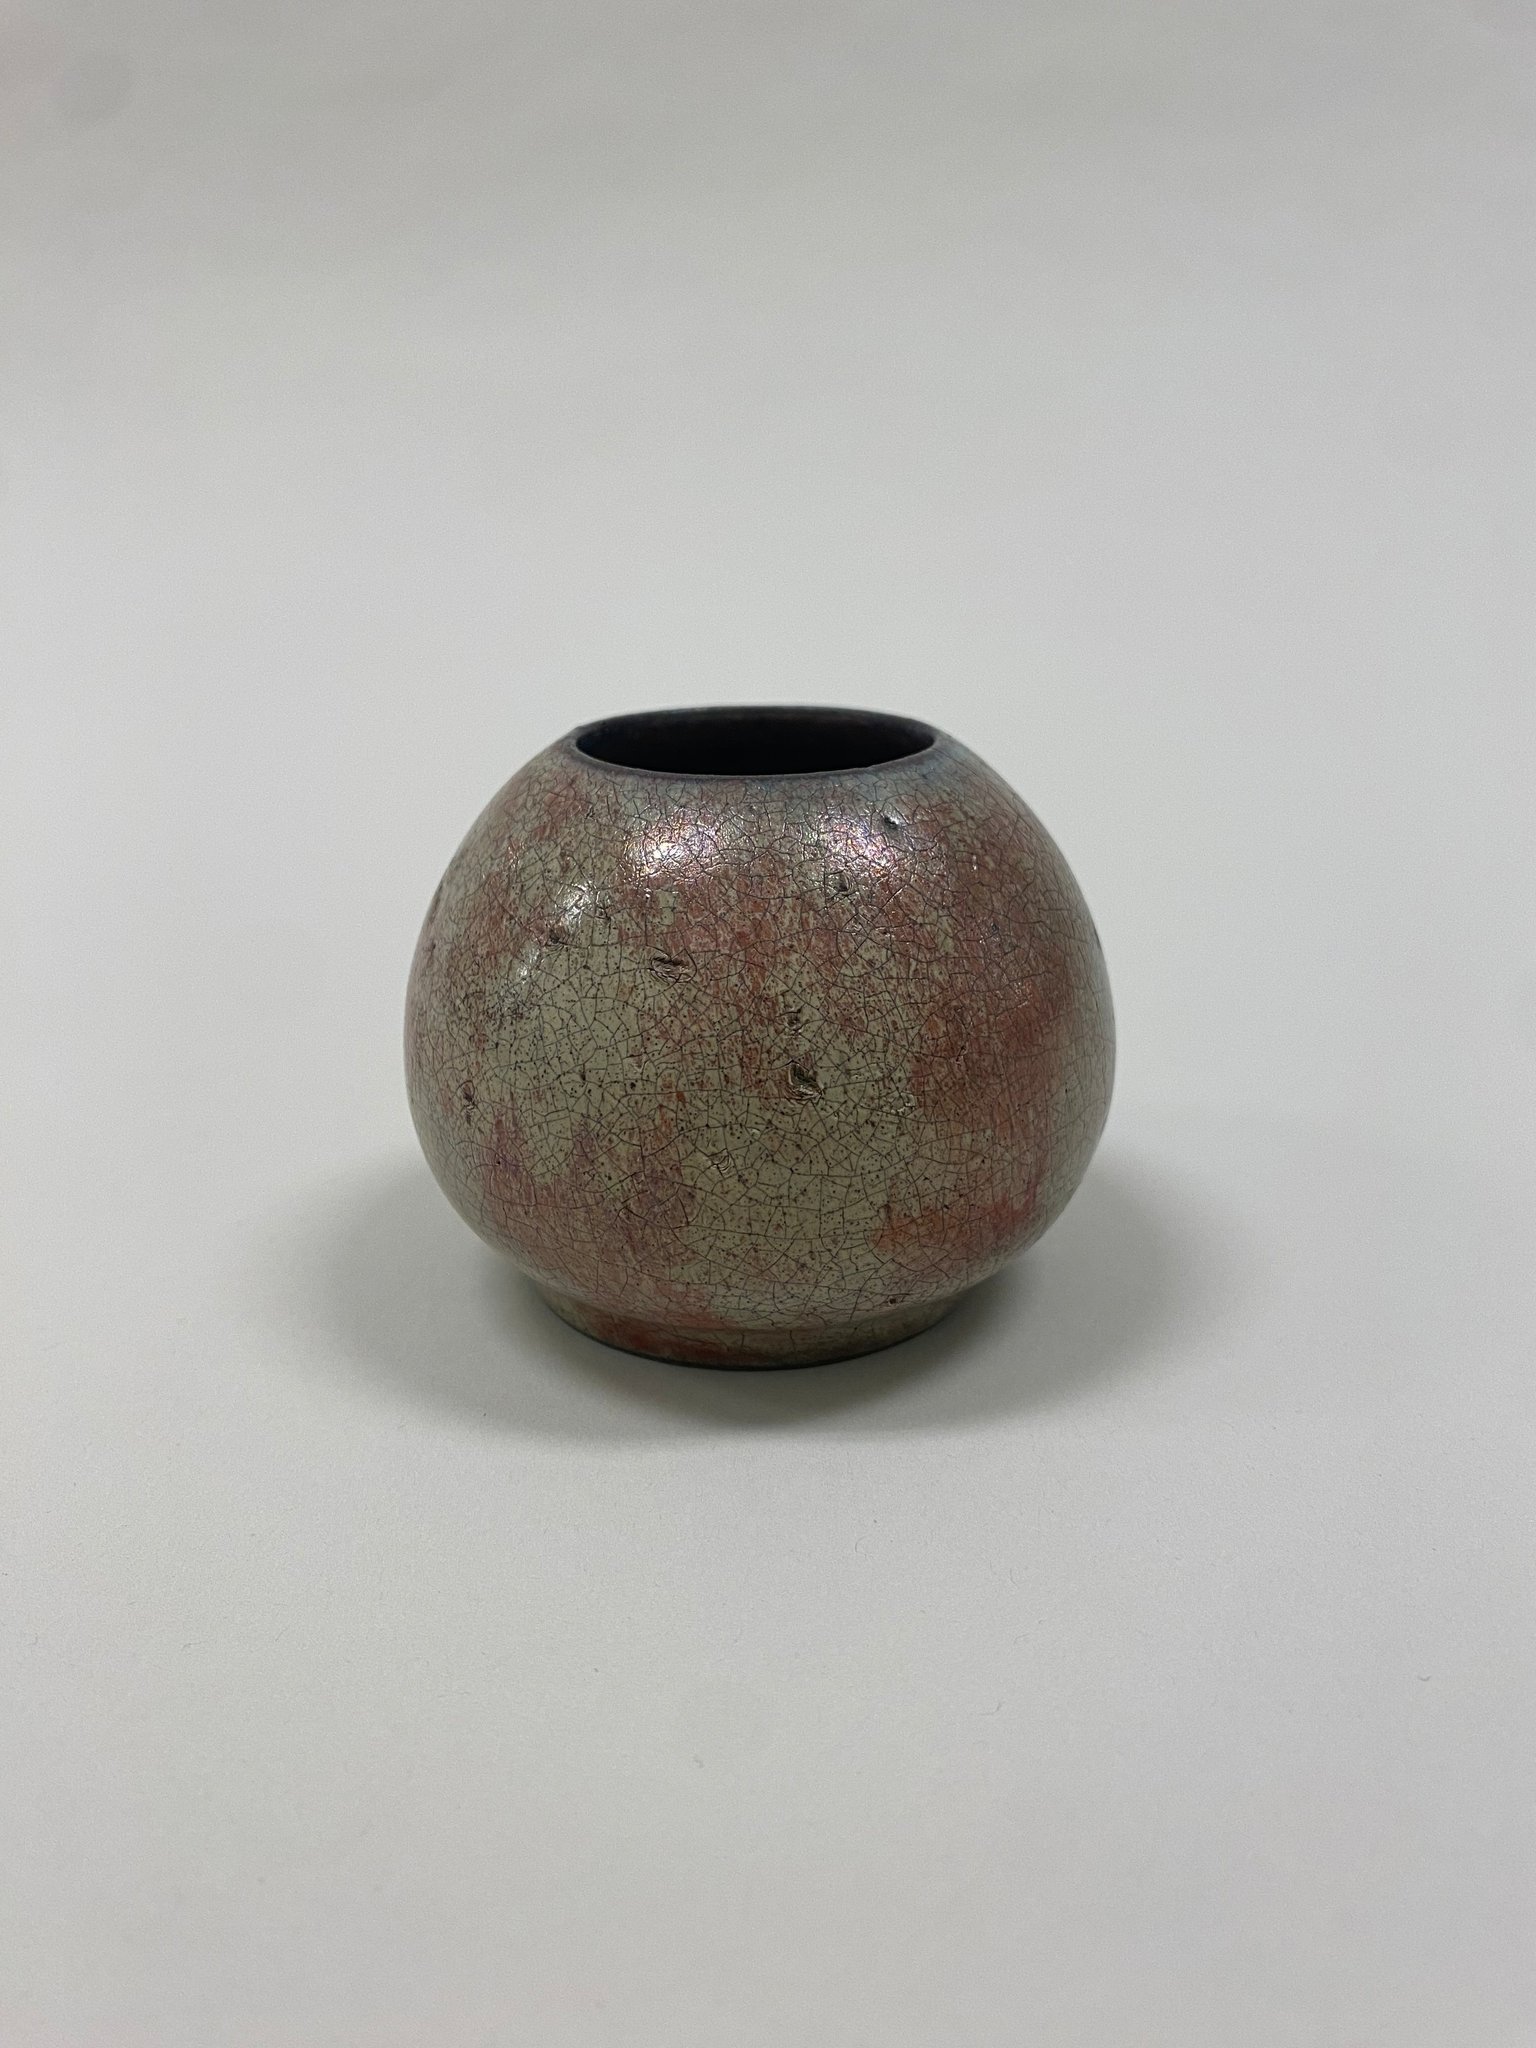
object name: jar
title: Water pot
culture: chinese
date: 1801-1900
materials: glaze, stoneware